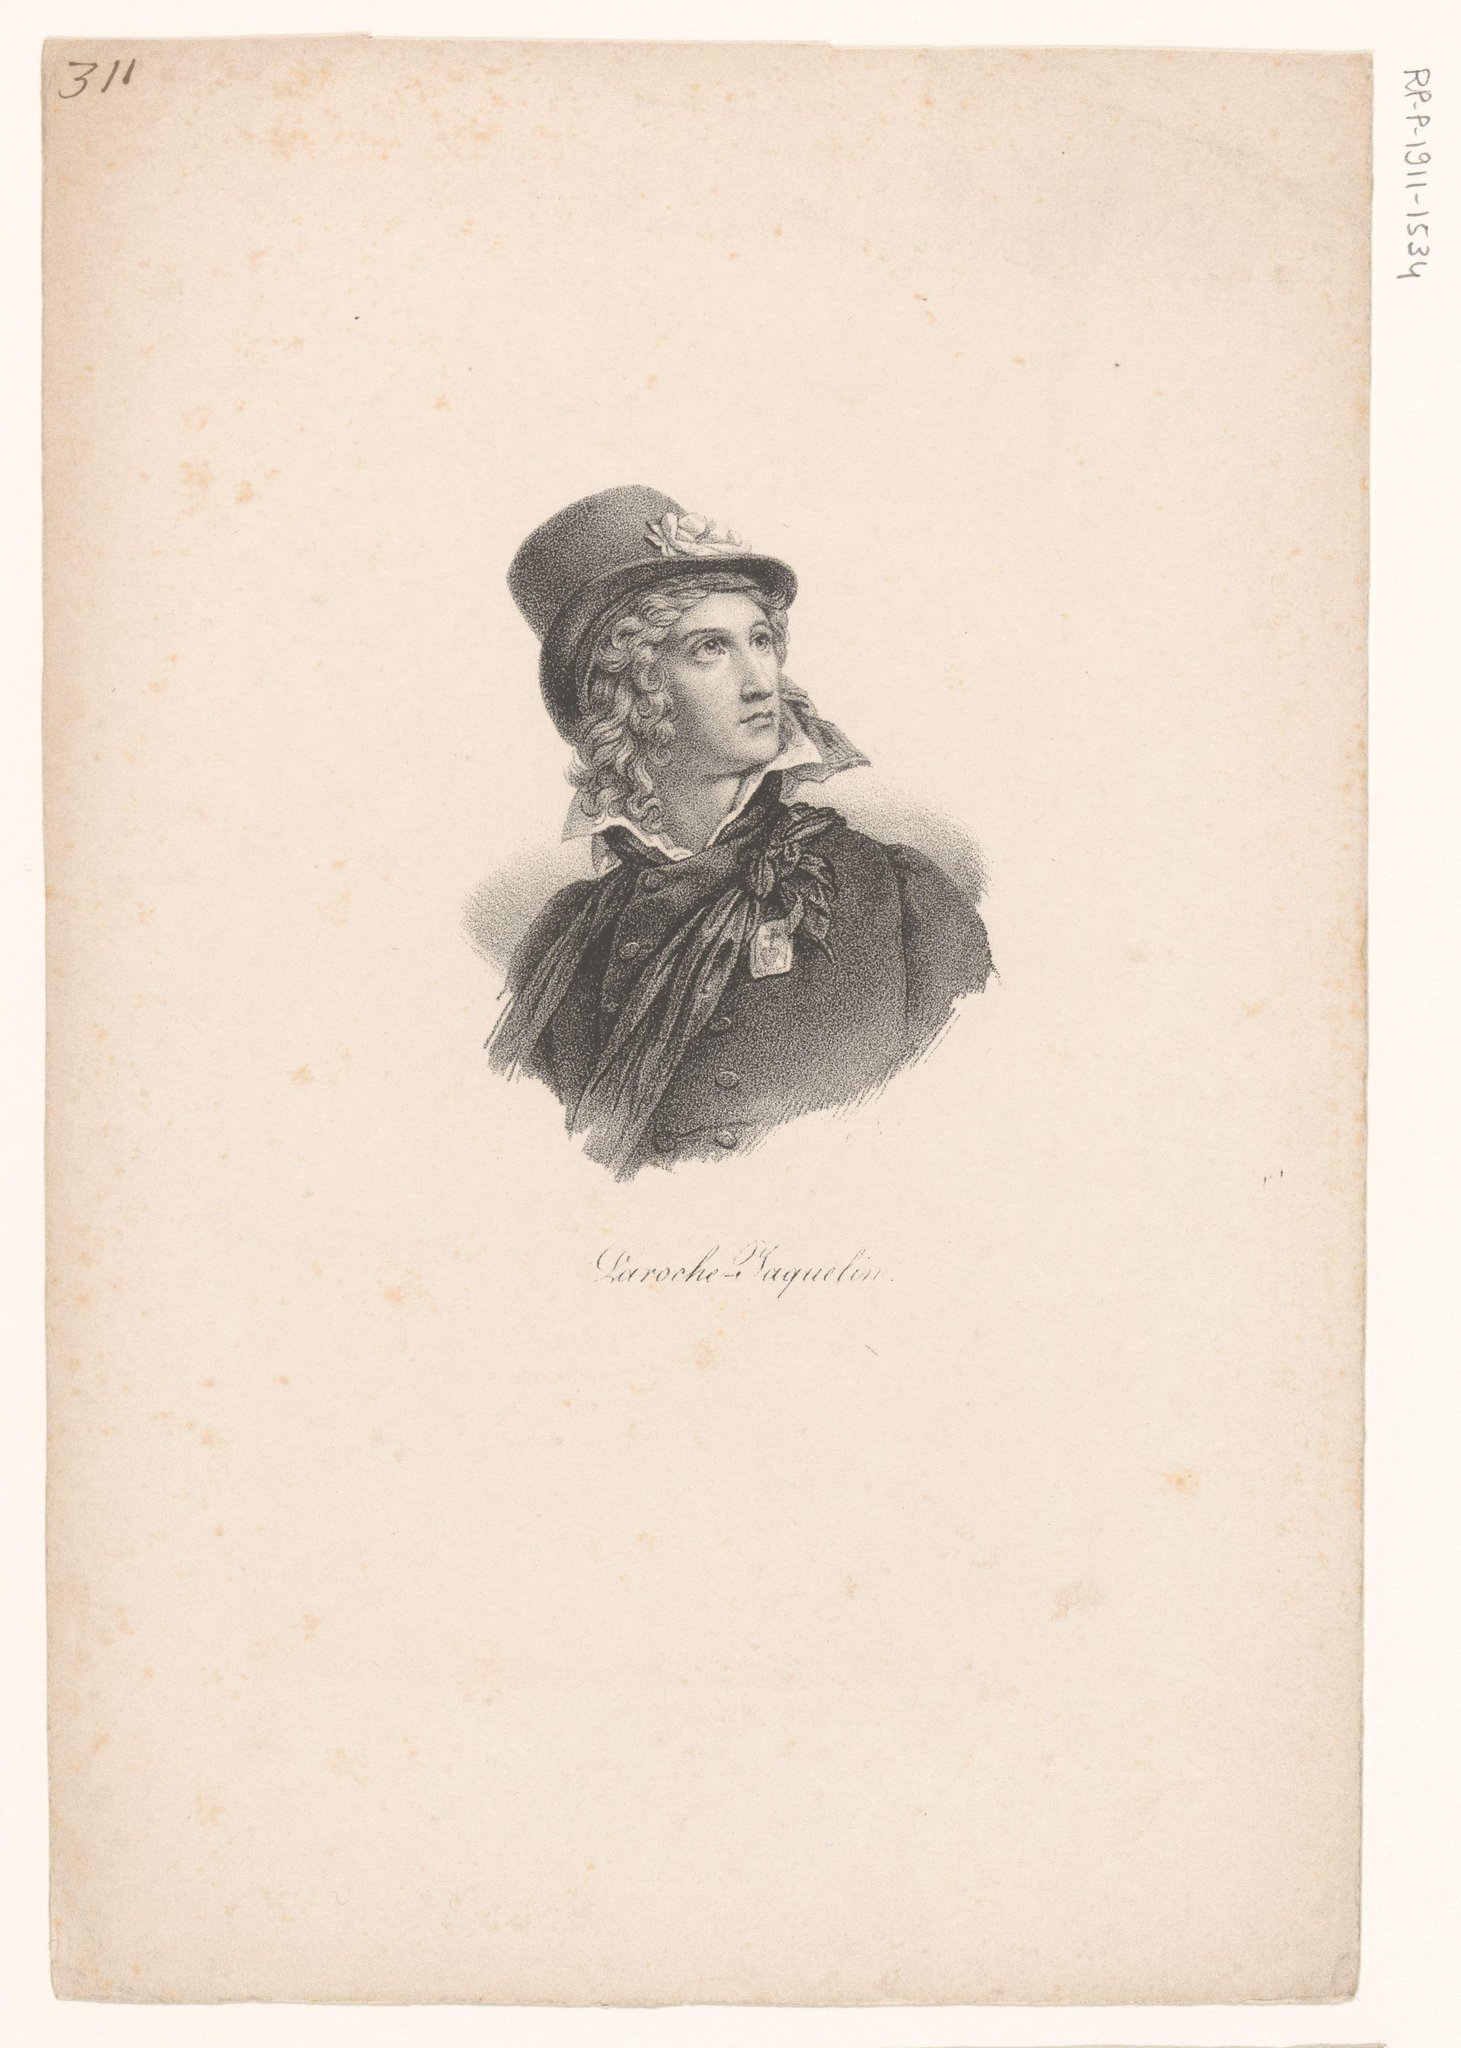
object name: print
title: Portret van Henri de la Rochejaquelein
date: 1818-1842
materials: paper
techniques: lithograph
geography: paris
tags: earl, historical persons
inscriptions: collector's mark: Lugt 2228a